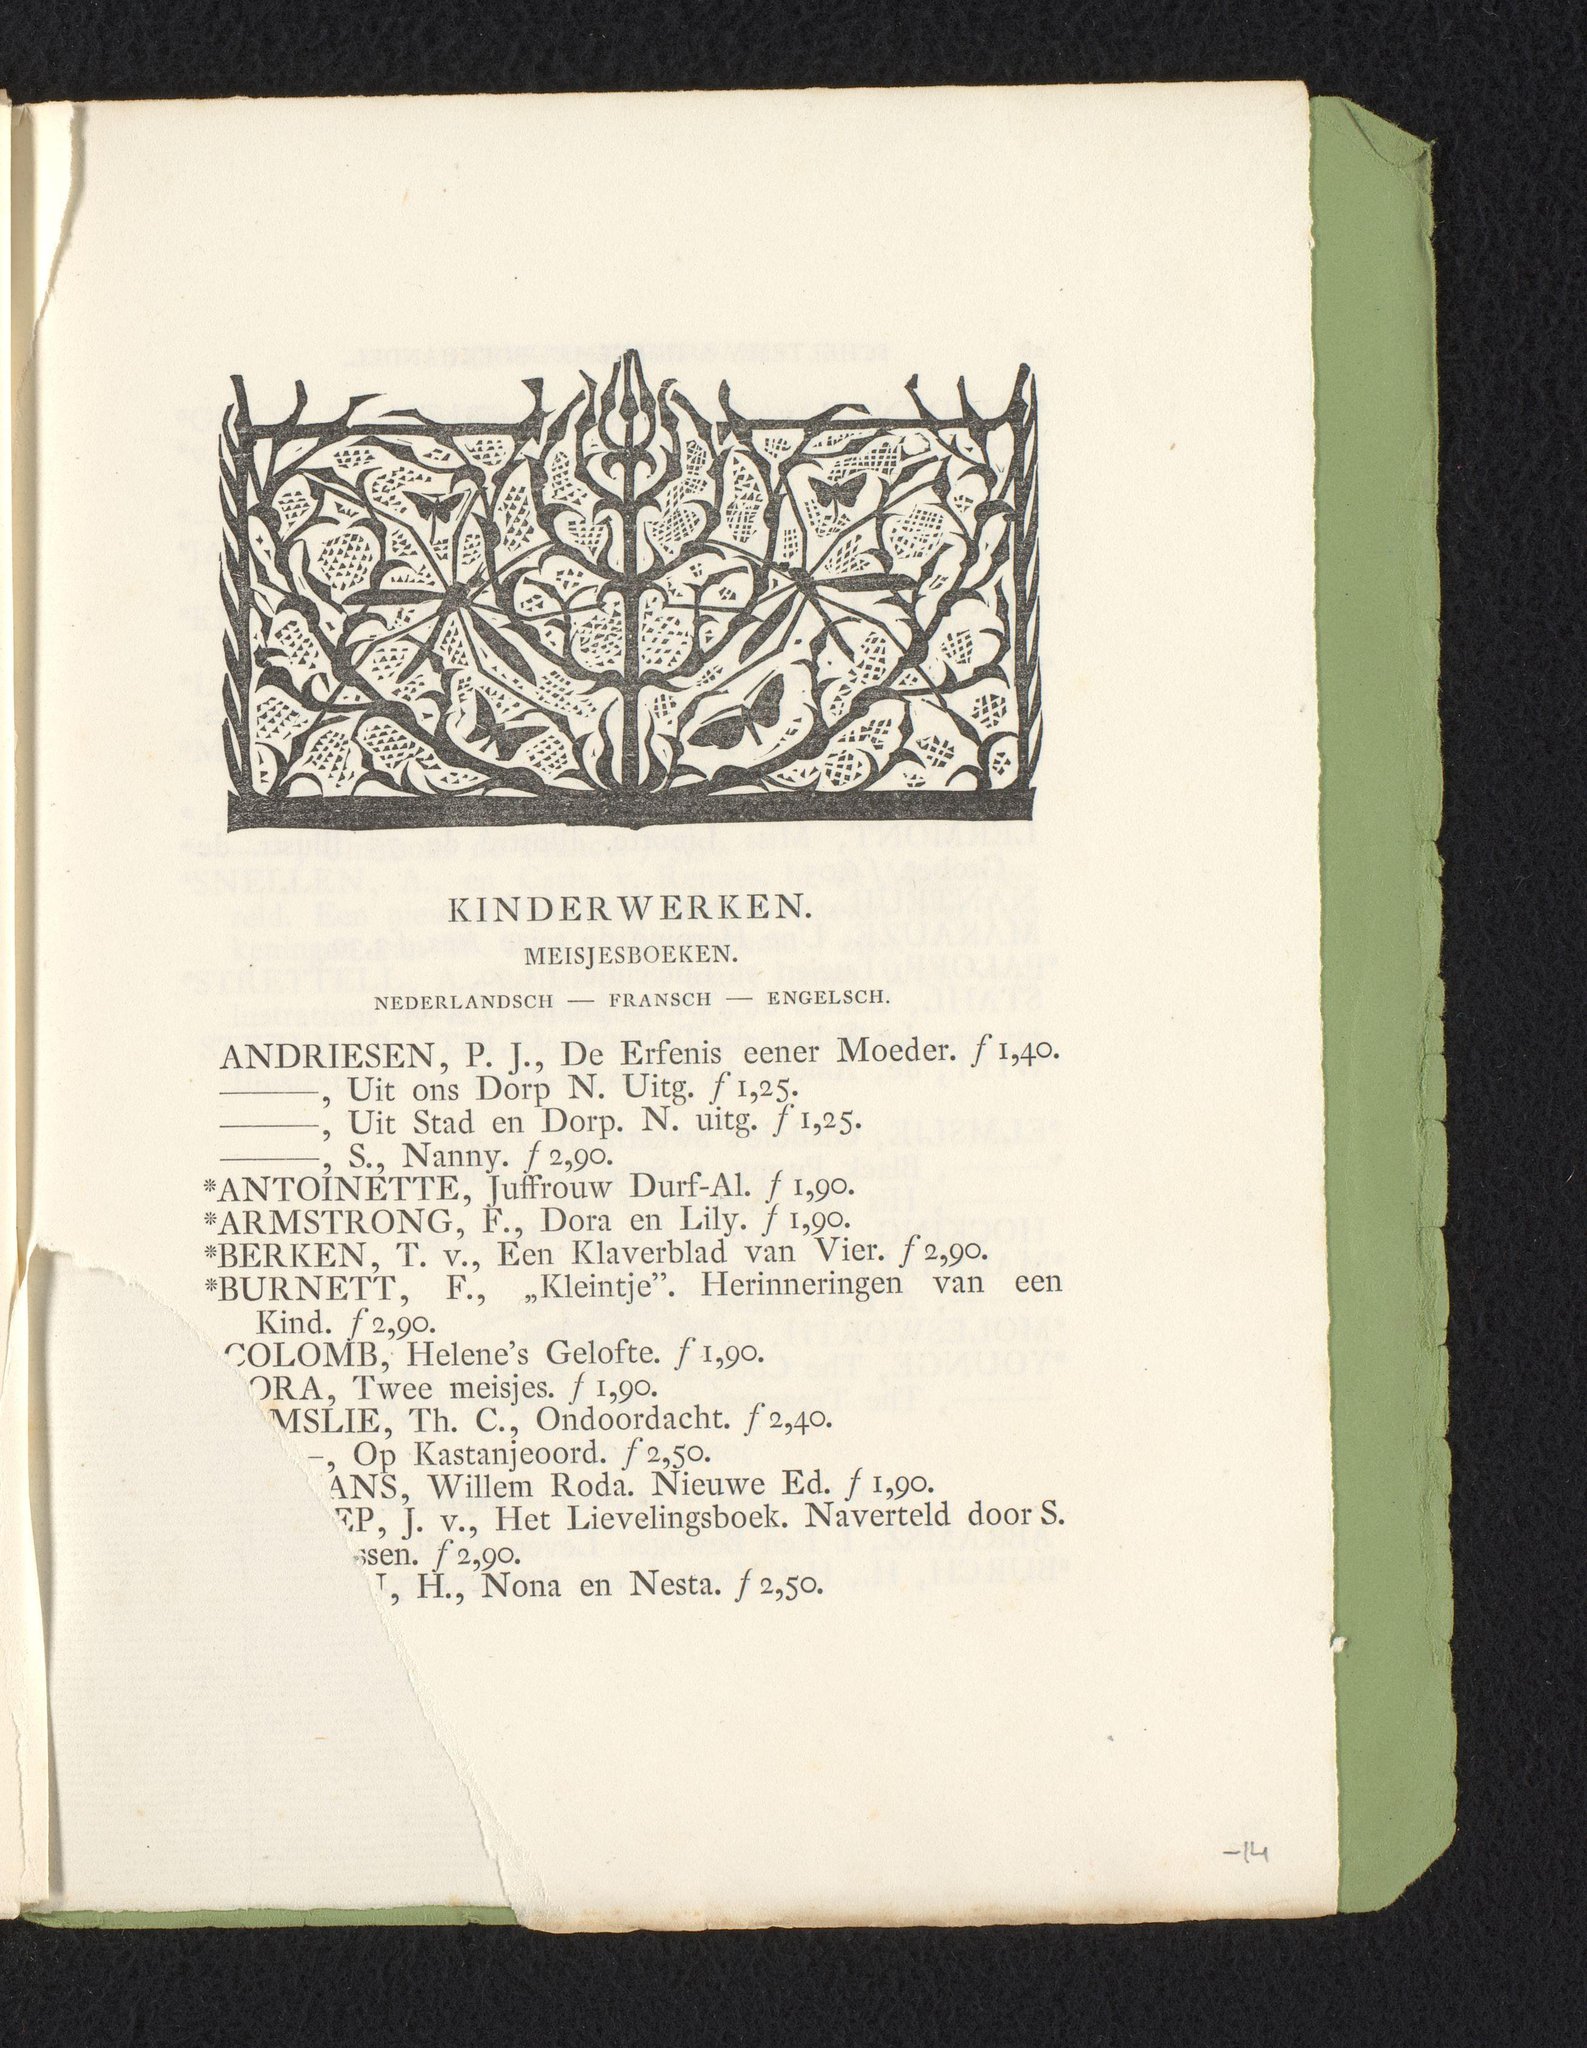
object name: print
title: Titelhoofd met langpootmuggen en motten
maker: gerrit willem dijsselhof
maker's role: designer, draughtsman, print maker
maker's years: 1866-1924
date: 1893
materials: paper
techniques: letterpress printing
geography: amsterdam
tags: insects: moth, insects: mosquito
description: Prent uit: Catalogus van handboeken, pracht- en plaatwerken, dicht- en prozabundels en kinderliteratuur (...). Amsterdam: Scheltema & Holkema's Boekhandel, 1894, p. 27. Deze prent werd origineel ontworpen ter illustratie van: Crane, Walter. Kunst en samenleving. [Vertaald uit het Engels door] Jan Veth. Amsterdam: Scheltema & Holkema's Boekhandel, 1894 [1893], p. 82.